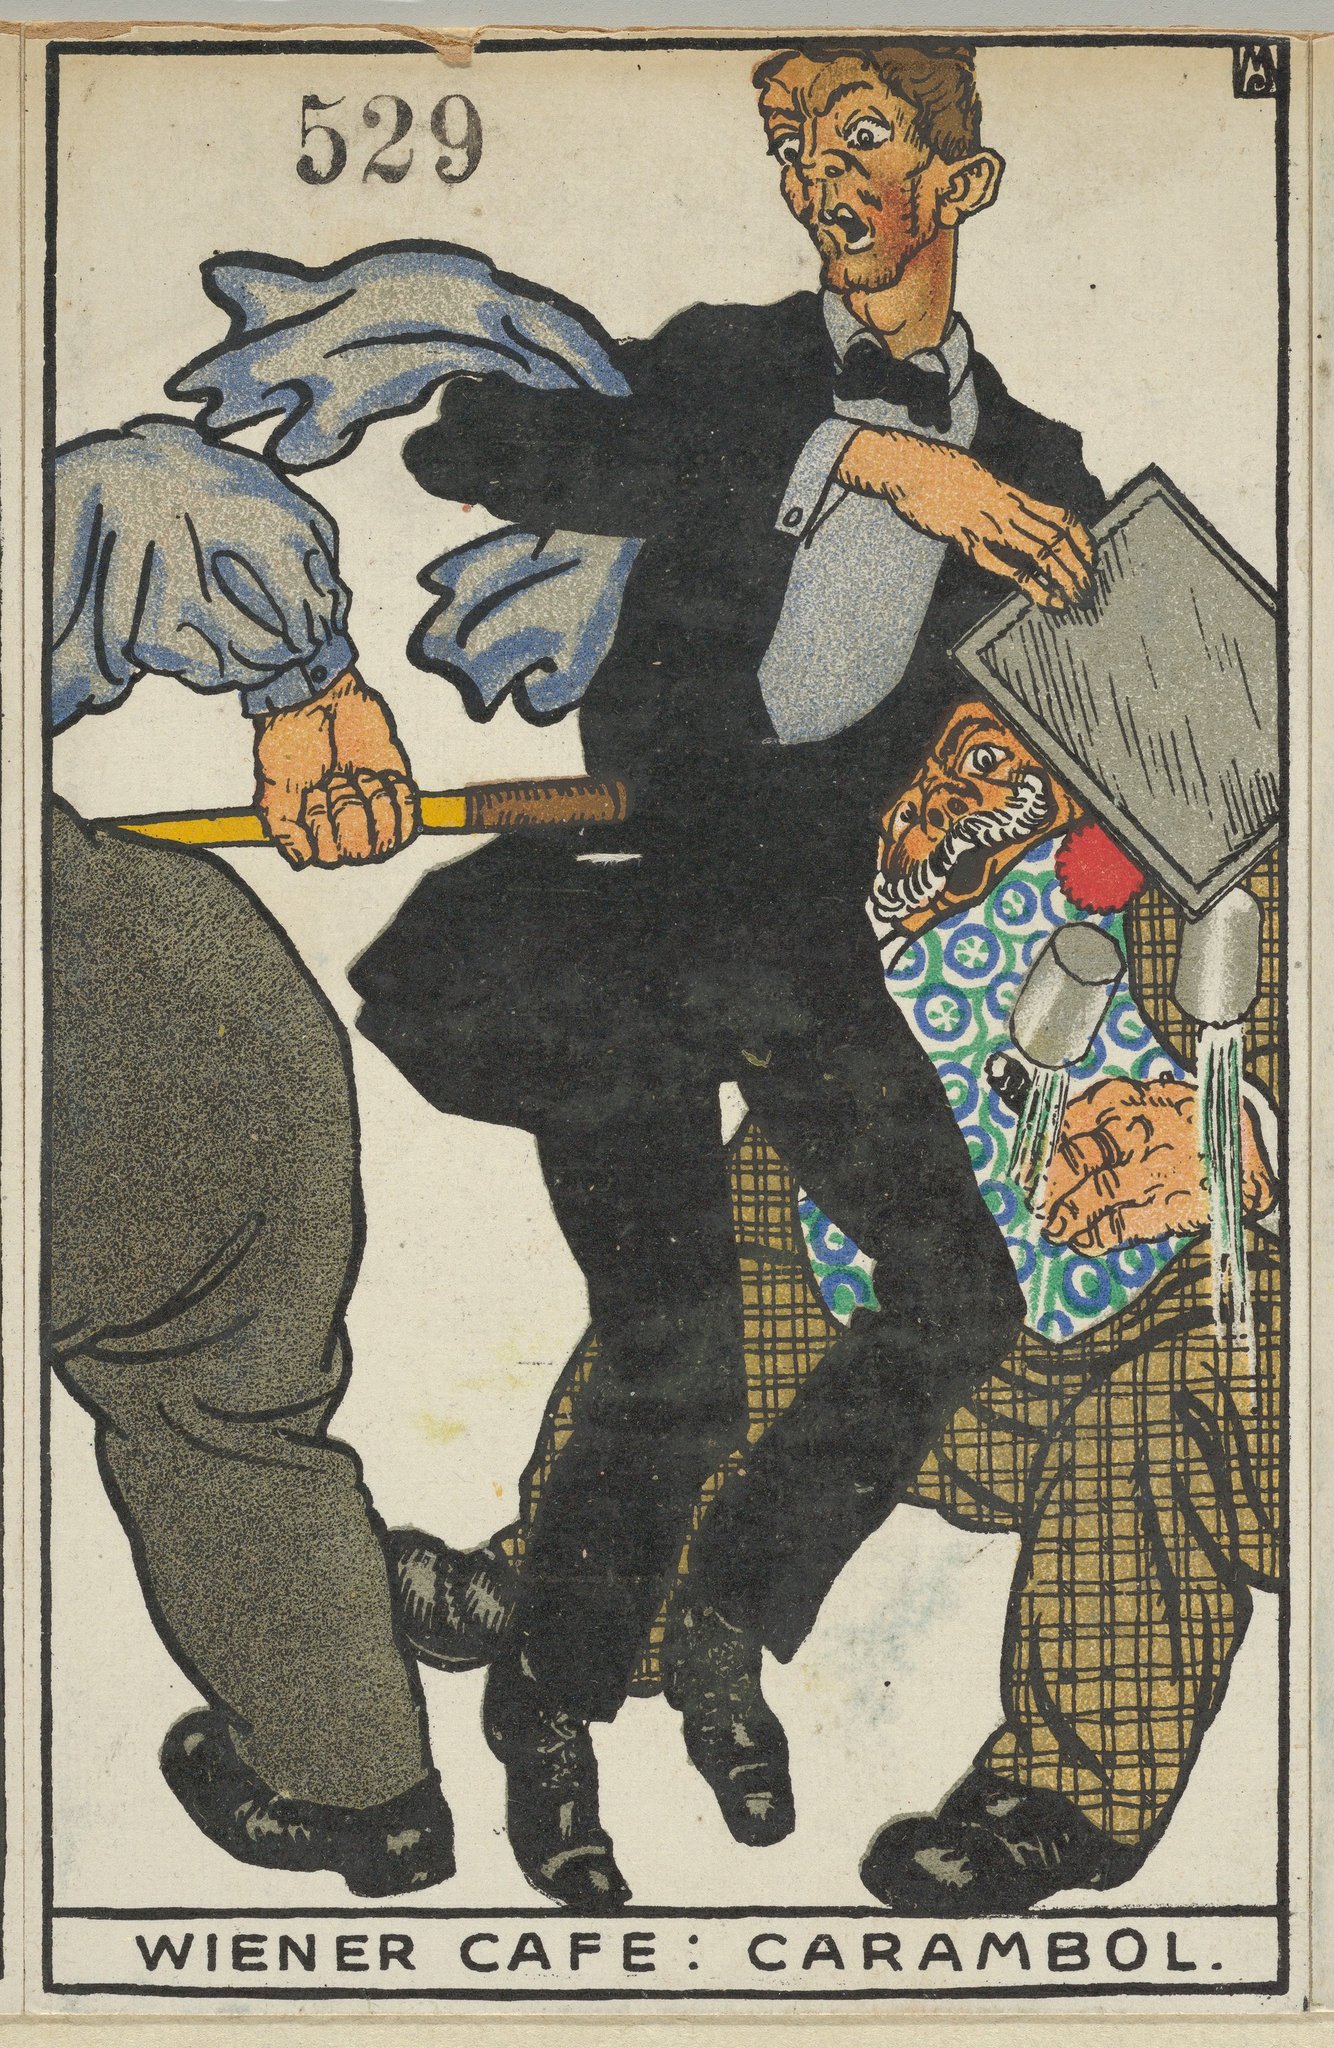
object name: print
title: Viennese Café: Carambole (Wiener Café: Carabol)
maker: moriz jung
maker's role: artist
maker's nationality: austrian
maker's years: 1885-1915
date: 1911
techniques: lithograph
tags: men